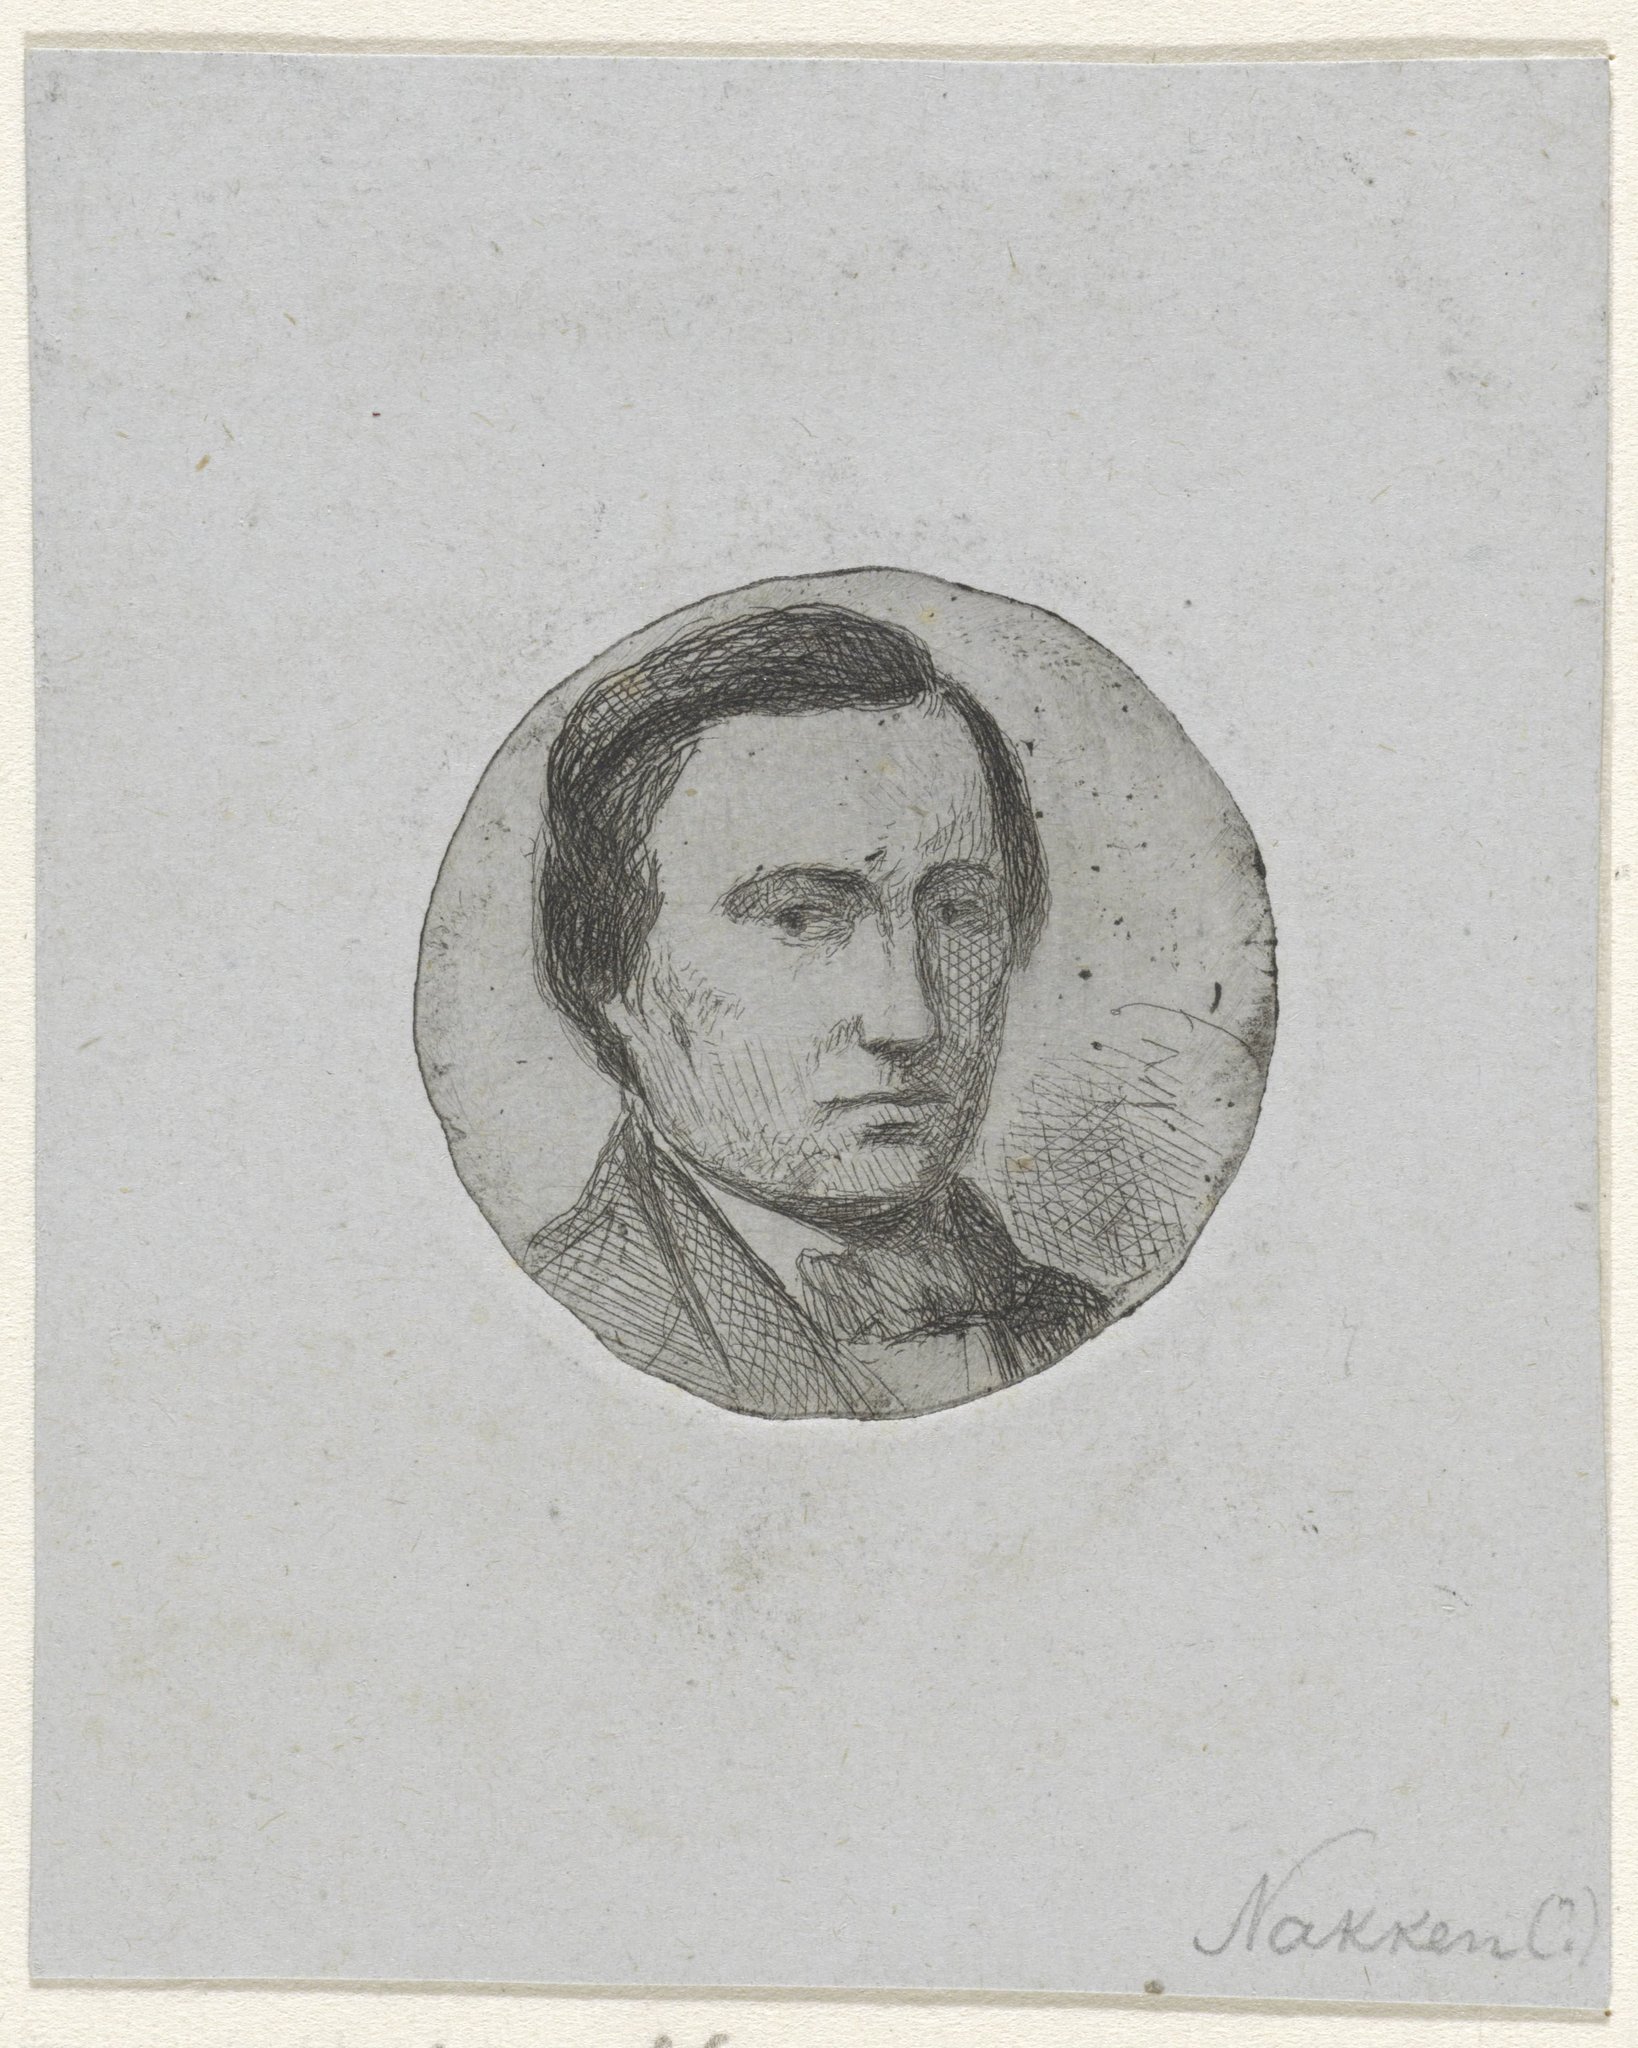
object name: print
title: Portret van Carel Vosmaer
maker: jan weissenbruch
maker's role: painter, print maker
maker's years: 1822-1880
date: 1837-1880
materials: paper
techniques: etching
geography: the hague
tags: the hague, print maker, draughtsman, carel vosmaer, historical persons, portrait, self-portrait of artist